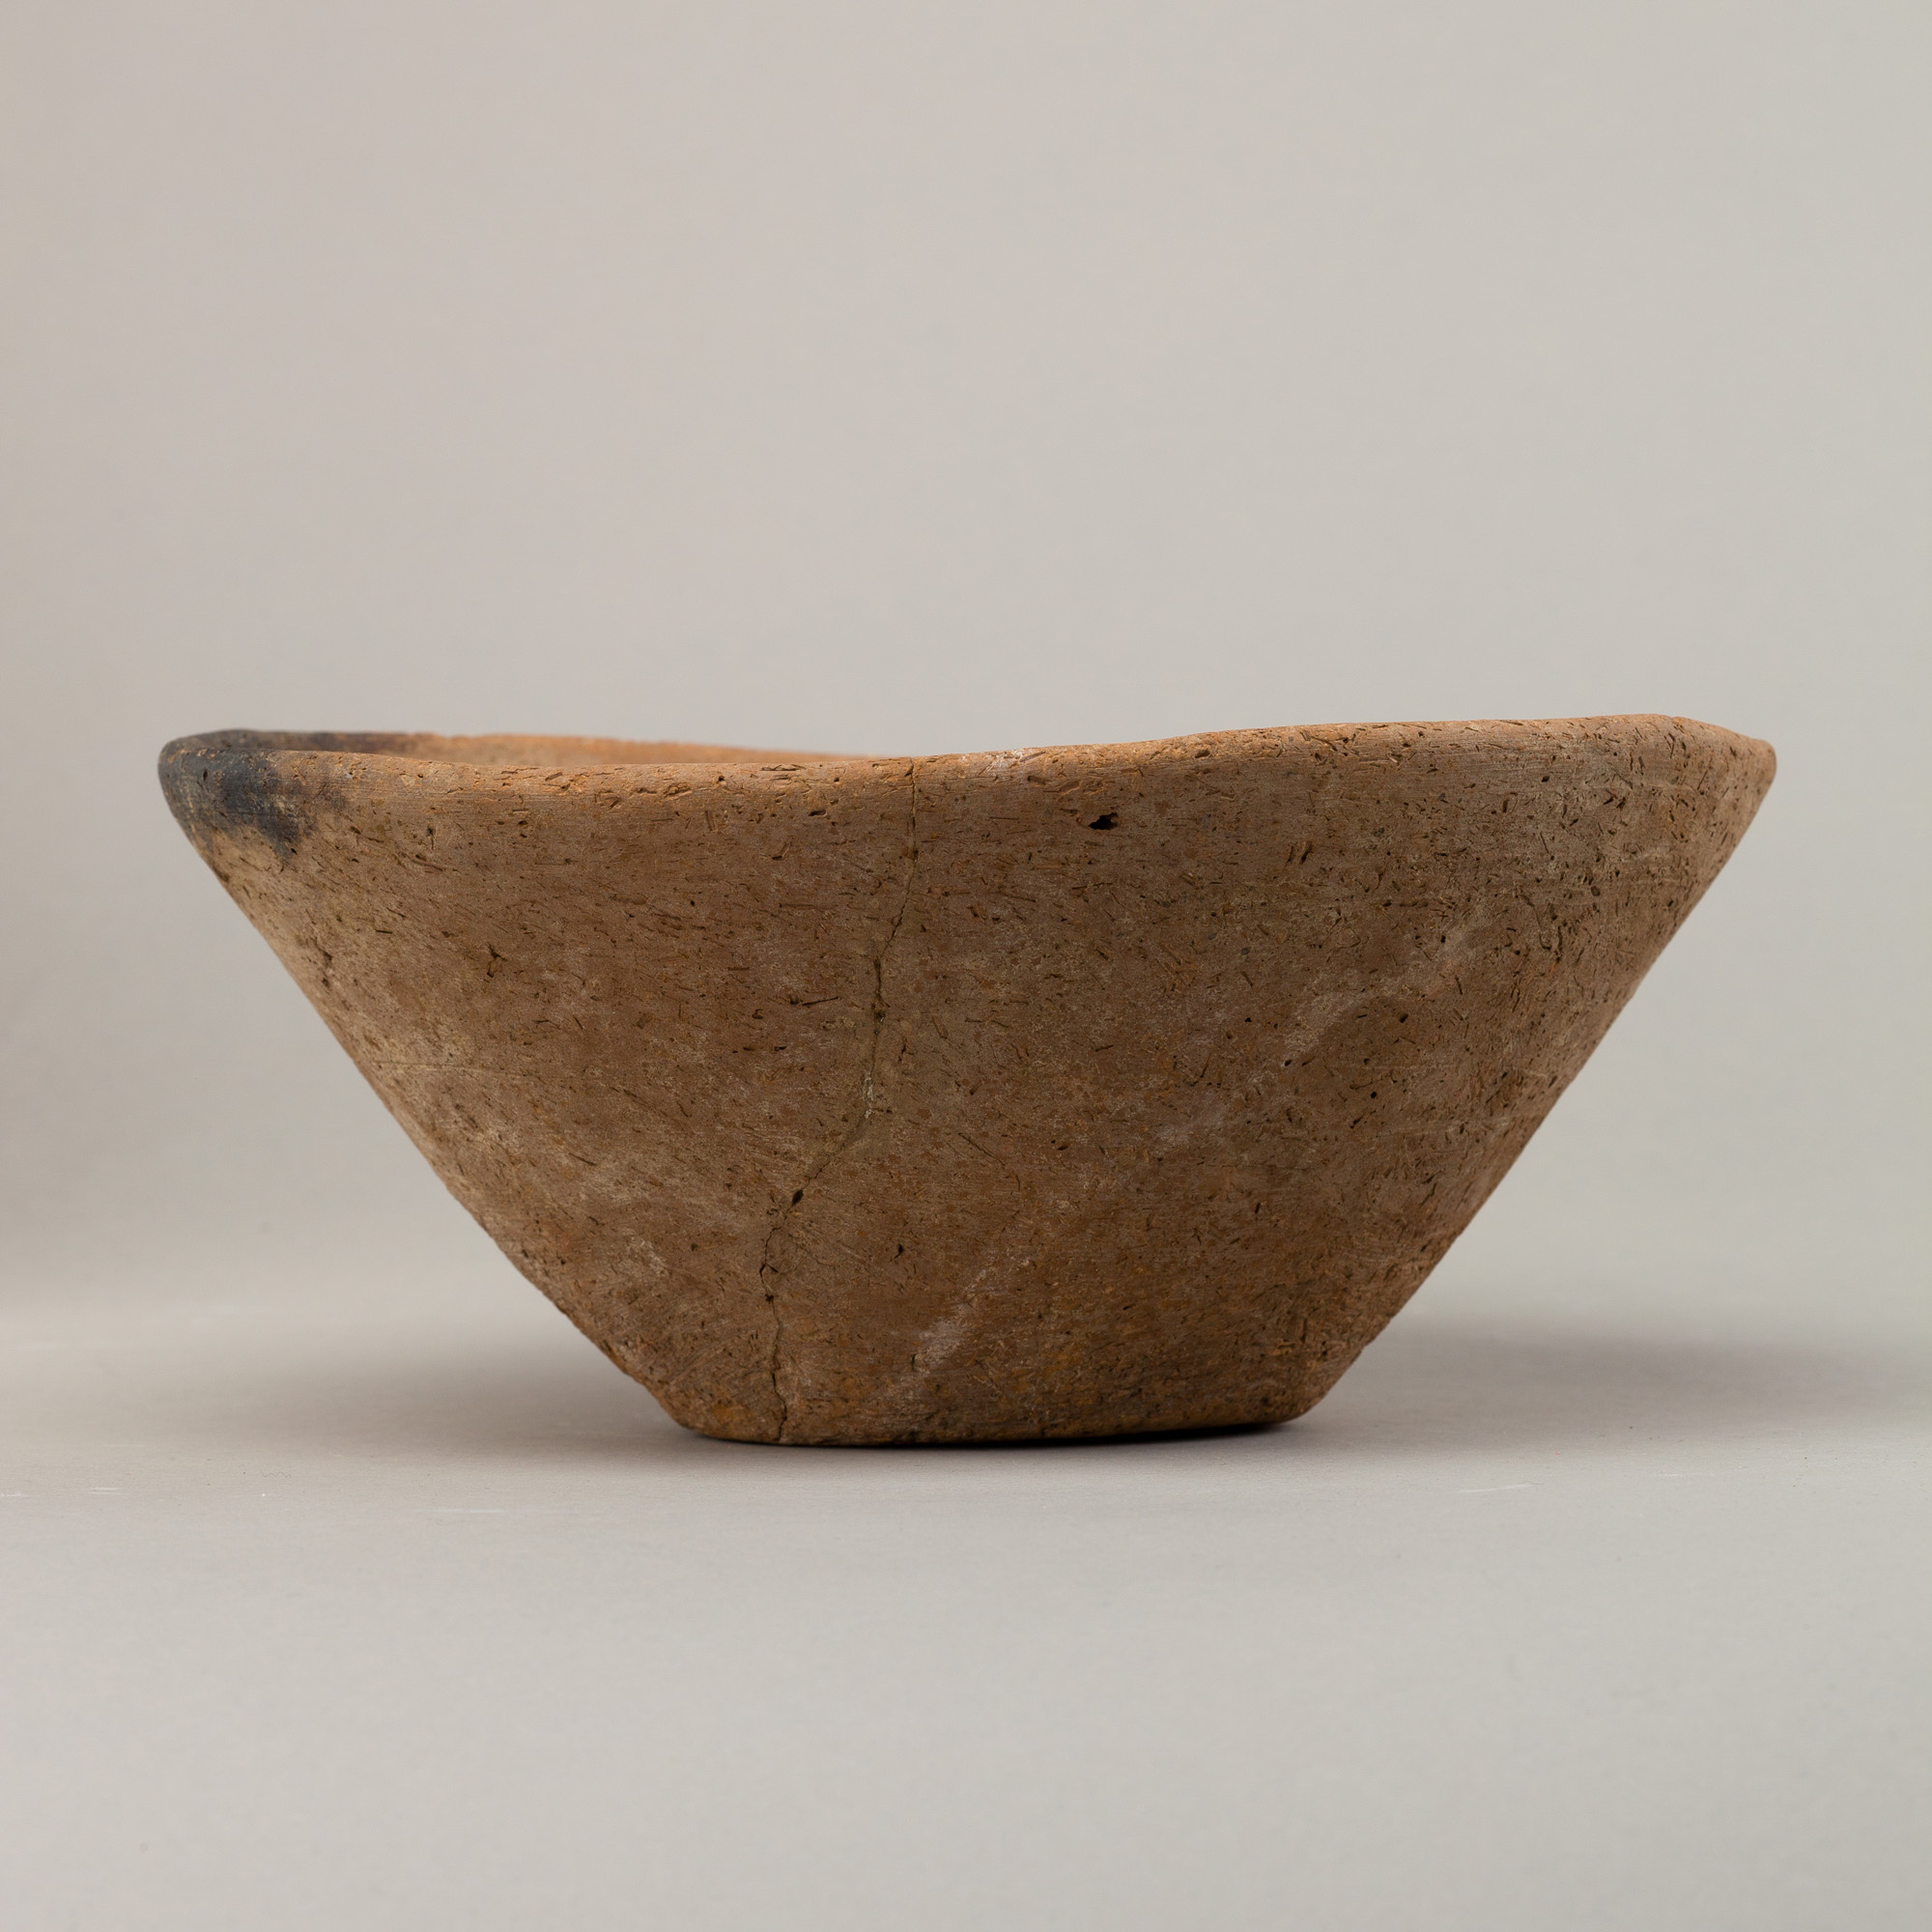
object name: bowl, deep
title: Deep bowl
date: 3850-2960 BCE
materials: pottery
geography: egypt